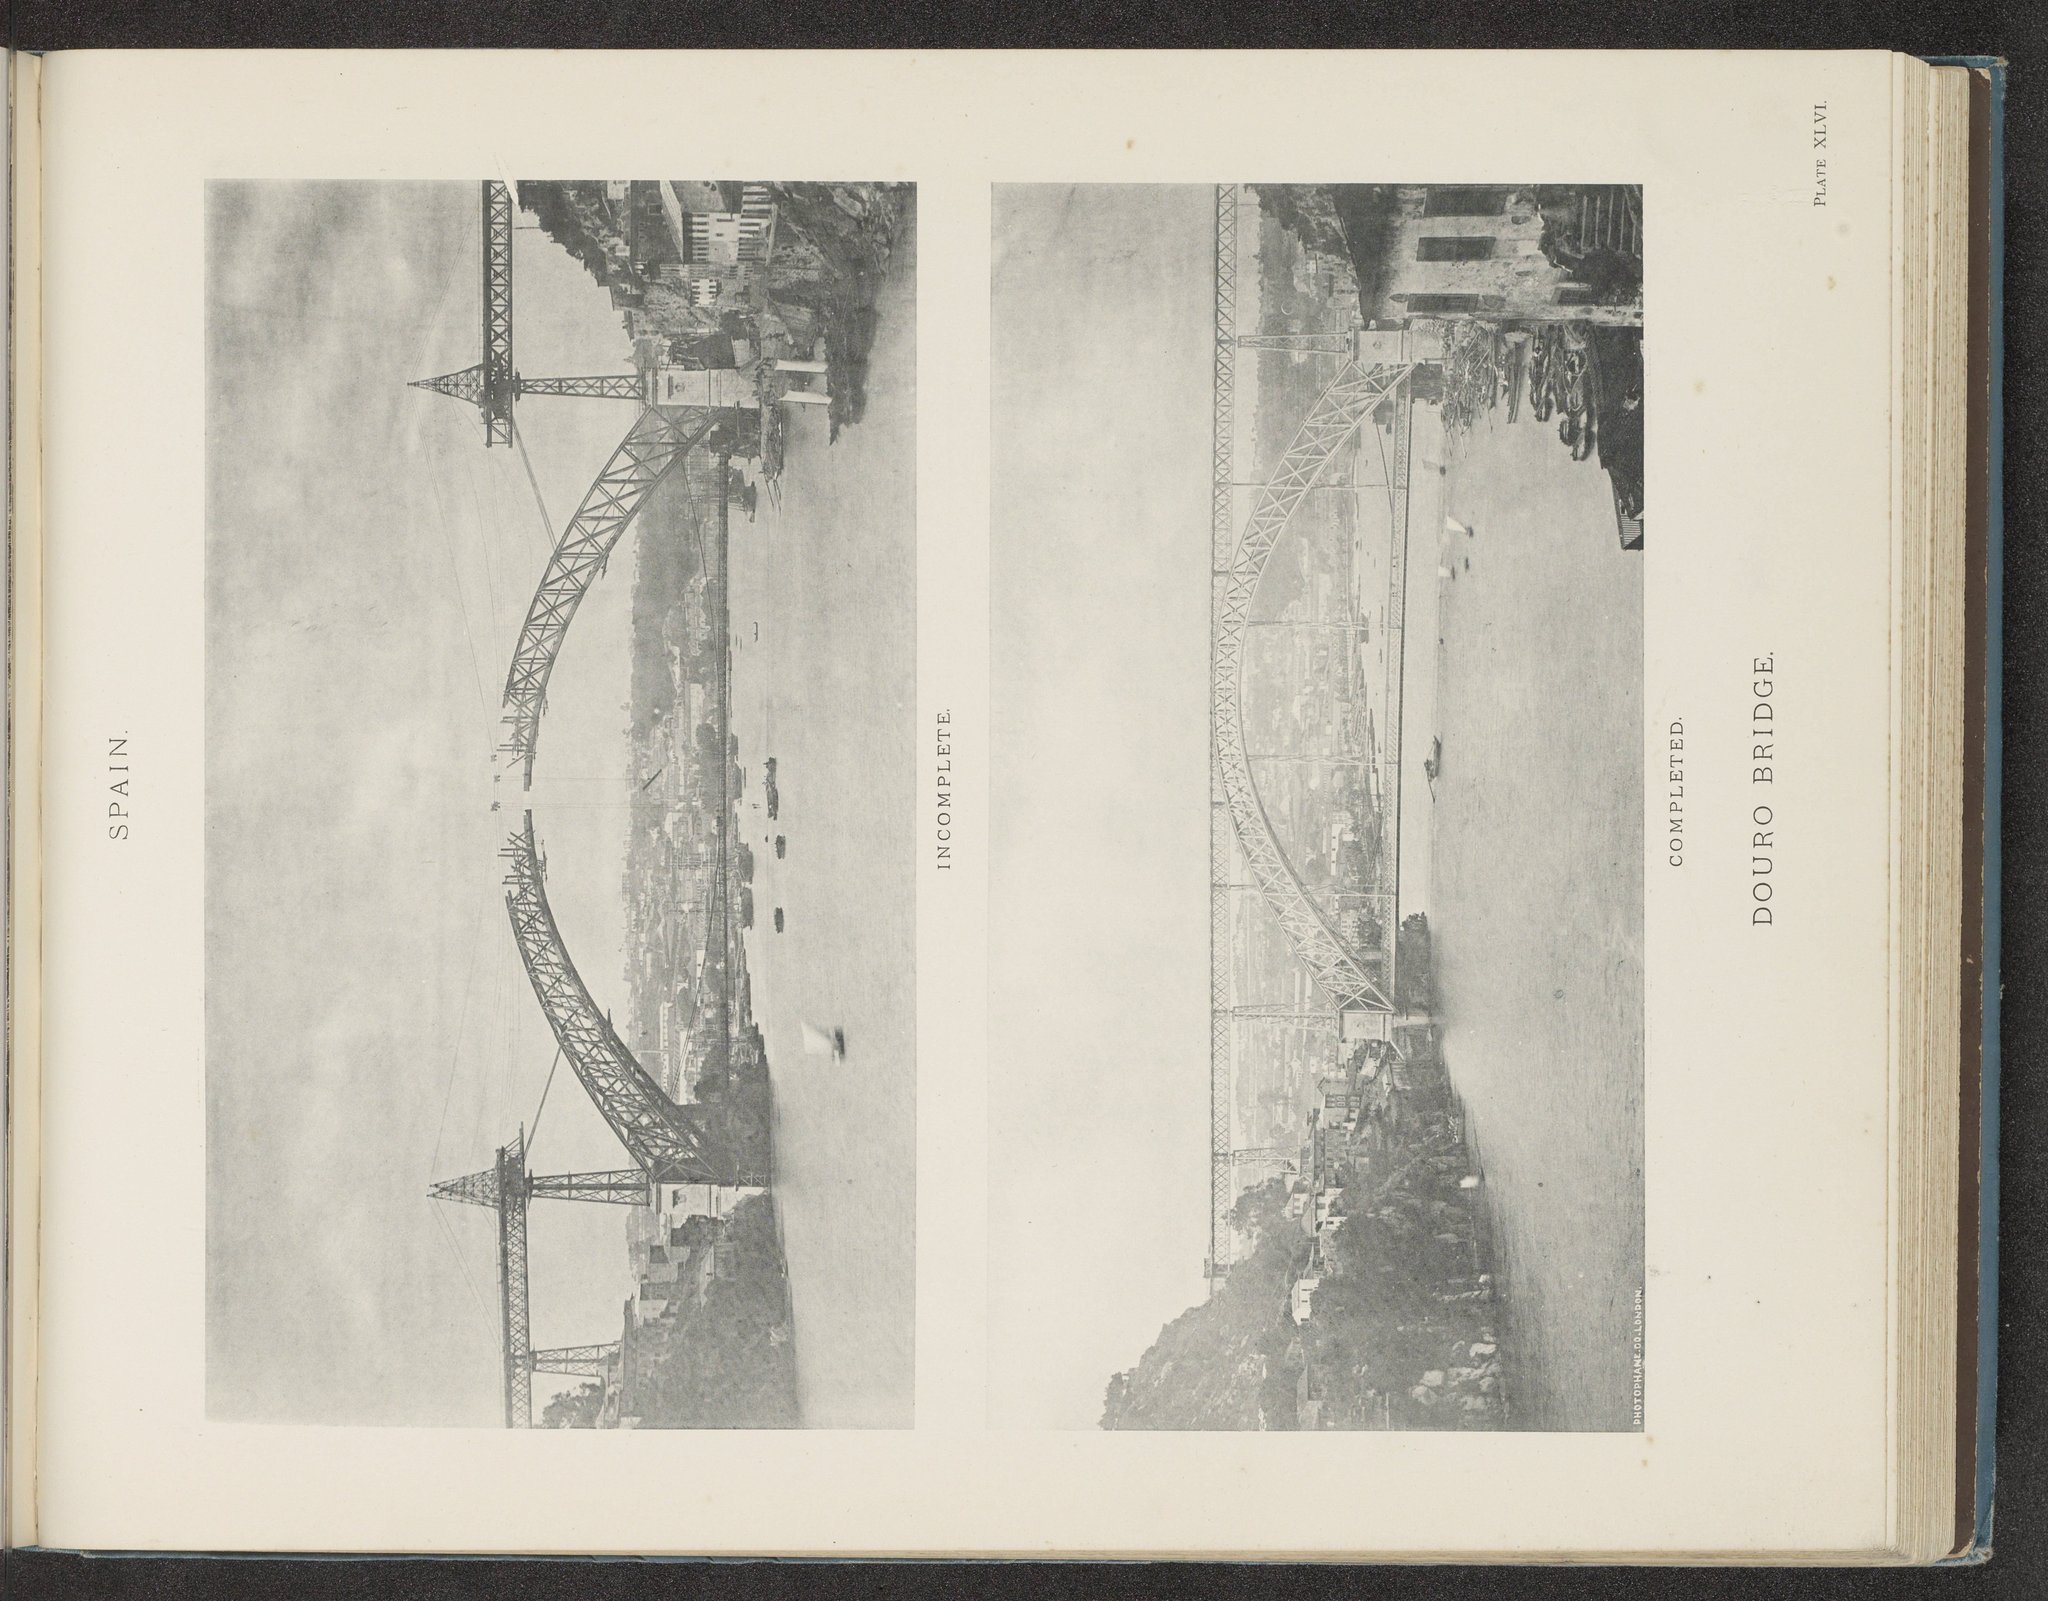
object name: photomechanical print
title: Douro Bridge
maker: Anonymous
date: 1886-1890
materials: paper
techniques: photograph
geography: london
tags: landscape with bridge, viaduct or aqueduct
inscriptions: number: ‘Plate XLVI.’, inscription: ‘Spain.’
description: Boven de brug in aanbouw, onder de complete brug.